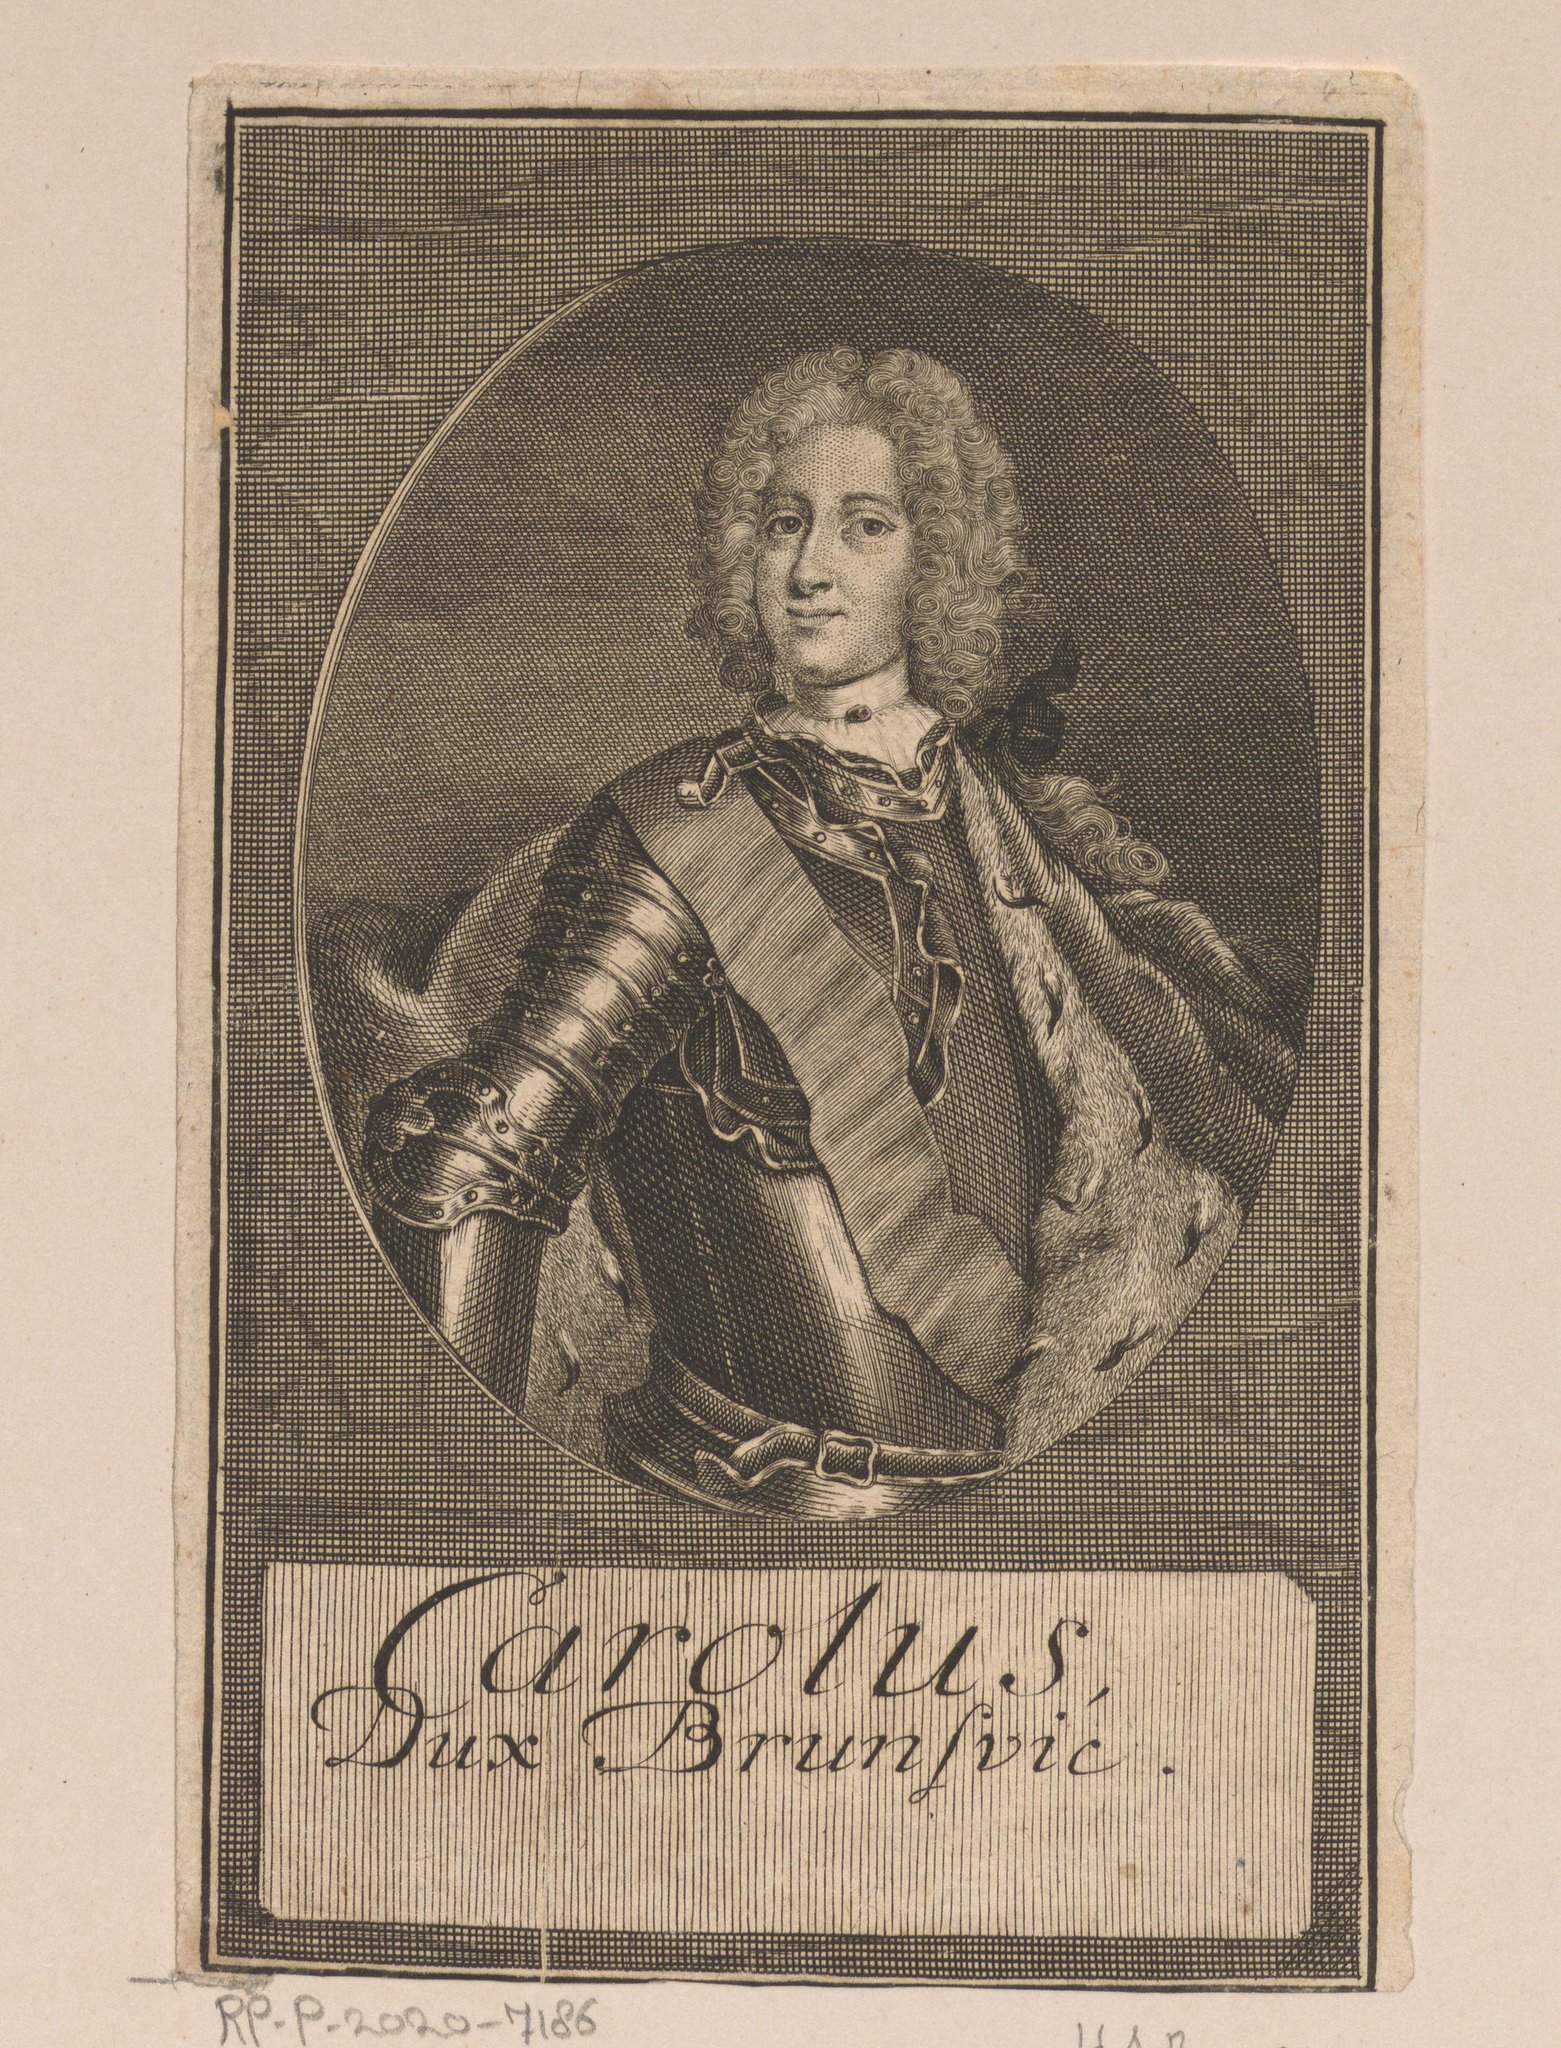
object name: print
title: Portret van Karel I van Brunswijk-Wolfenbüttel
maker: Anonymous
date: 1735-1799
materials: paper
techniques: engraving, etching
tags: historical persons